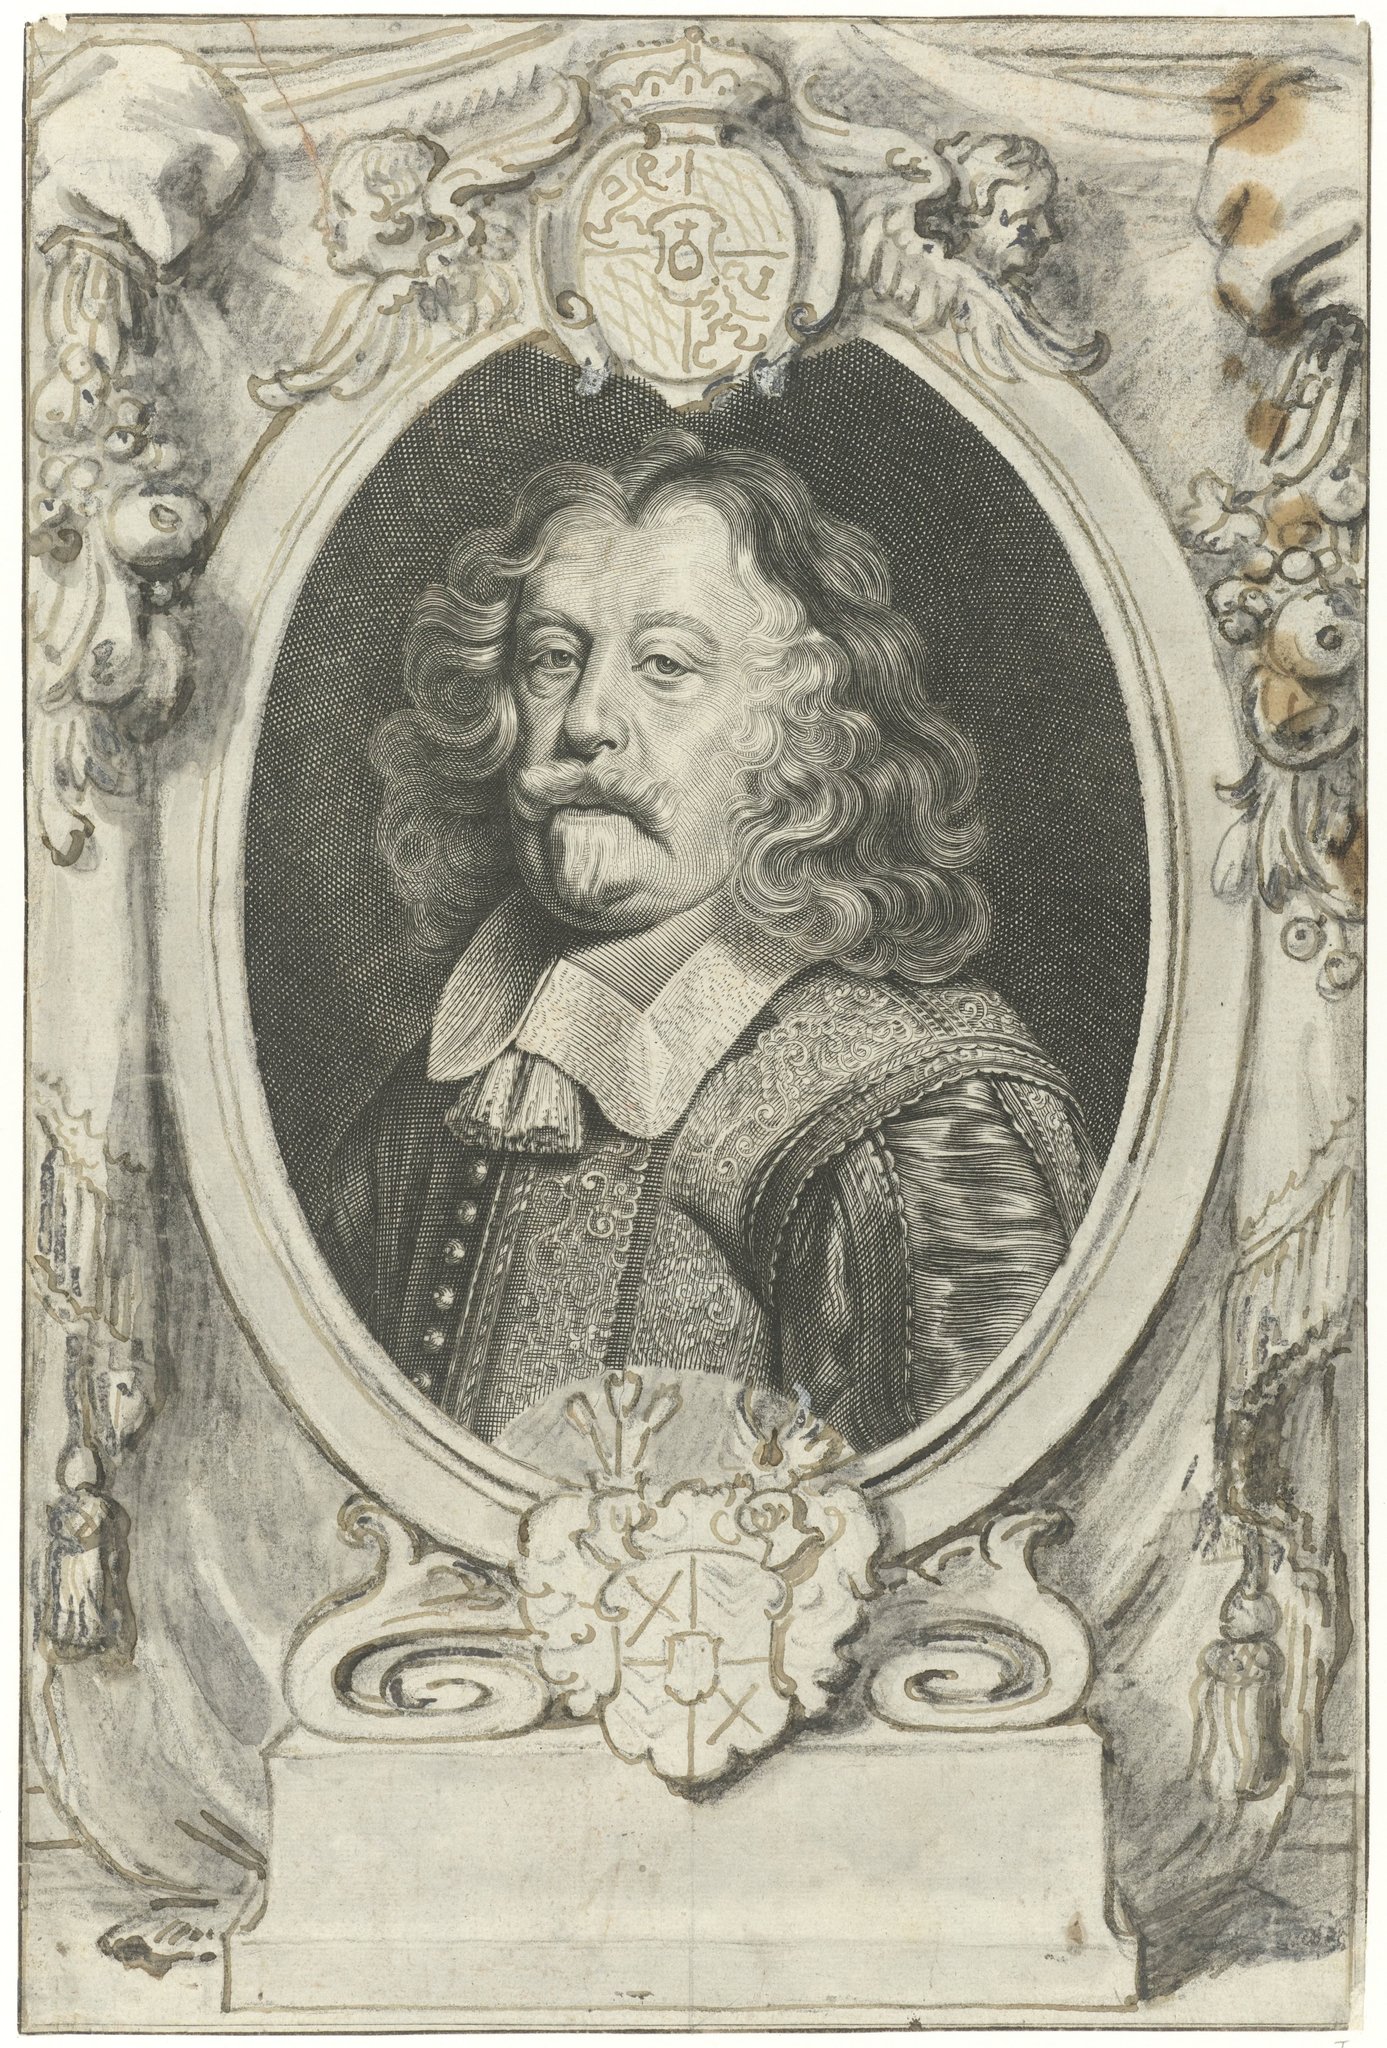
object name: print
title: Portret van Maximilian Kurtz von Senftenau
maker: pieter de jode (ii)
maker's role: draughtsman, print maker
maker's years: 1606-1674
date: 1658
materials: paper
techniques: brush, engraving, etching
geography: antwerp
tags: politician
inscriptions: inscription: ‘Diepenbeek’, collector's mark: Lugt 2228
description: Busteportret van Maximilian Kurtz von Senftenau. Het portret is gevat in een met sepia en zwarte inkt getekende ovale omlijsting met het wapenschild van de geportretteerde en decoraties. Prent uit een serie portretten naar schilderijen van Anselmus van Hulle van alle gedelegeerden bij de vredesonderhandelingen te Münster en Osnabrück.